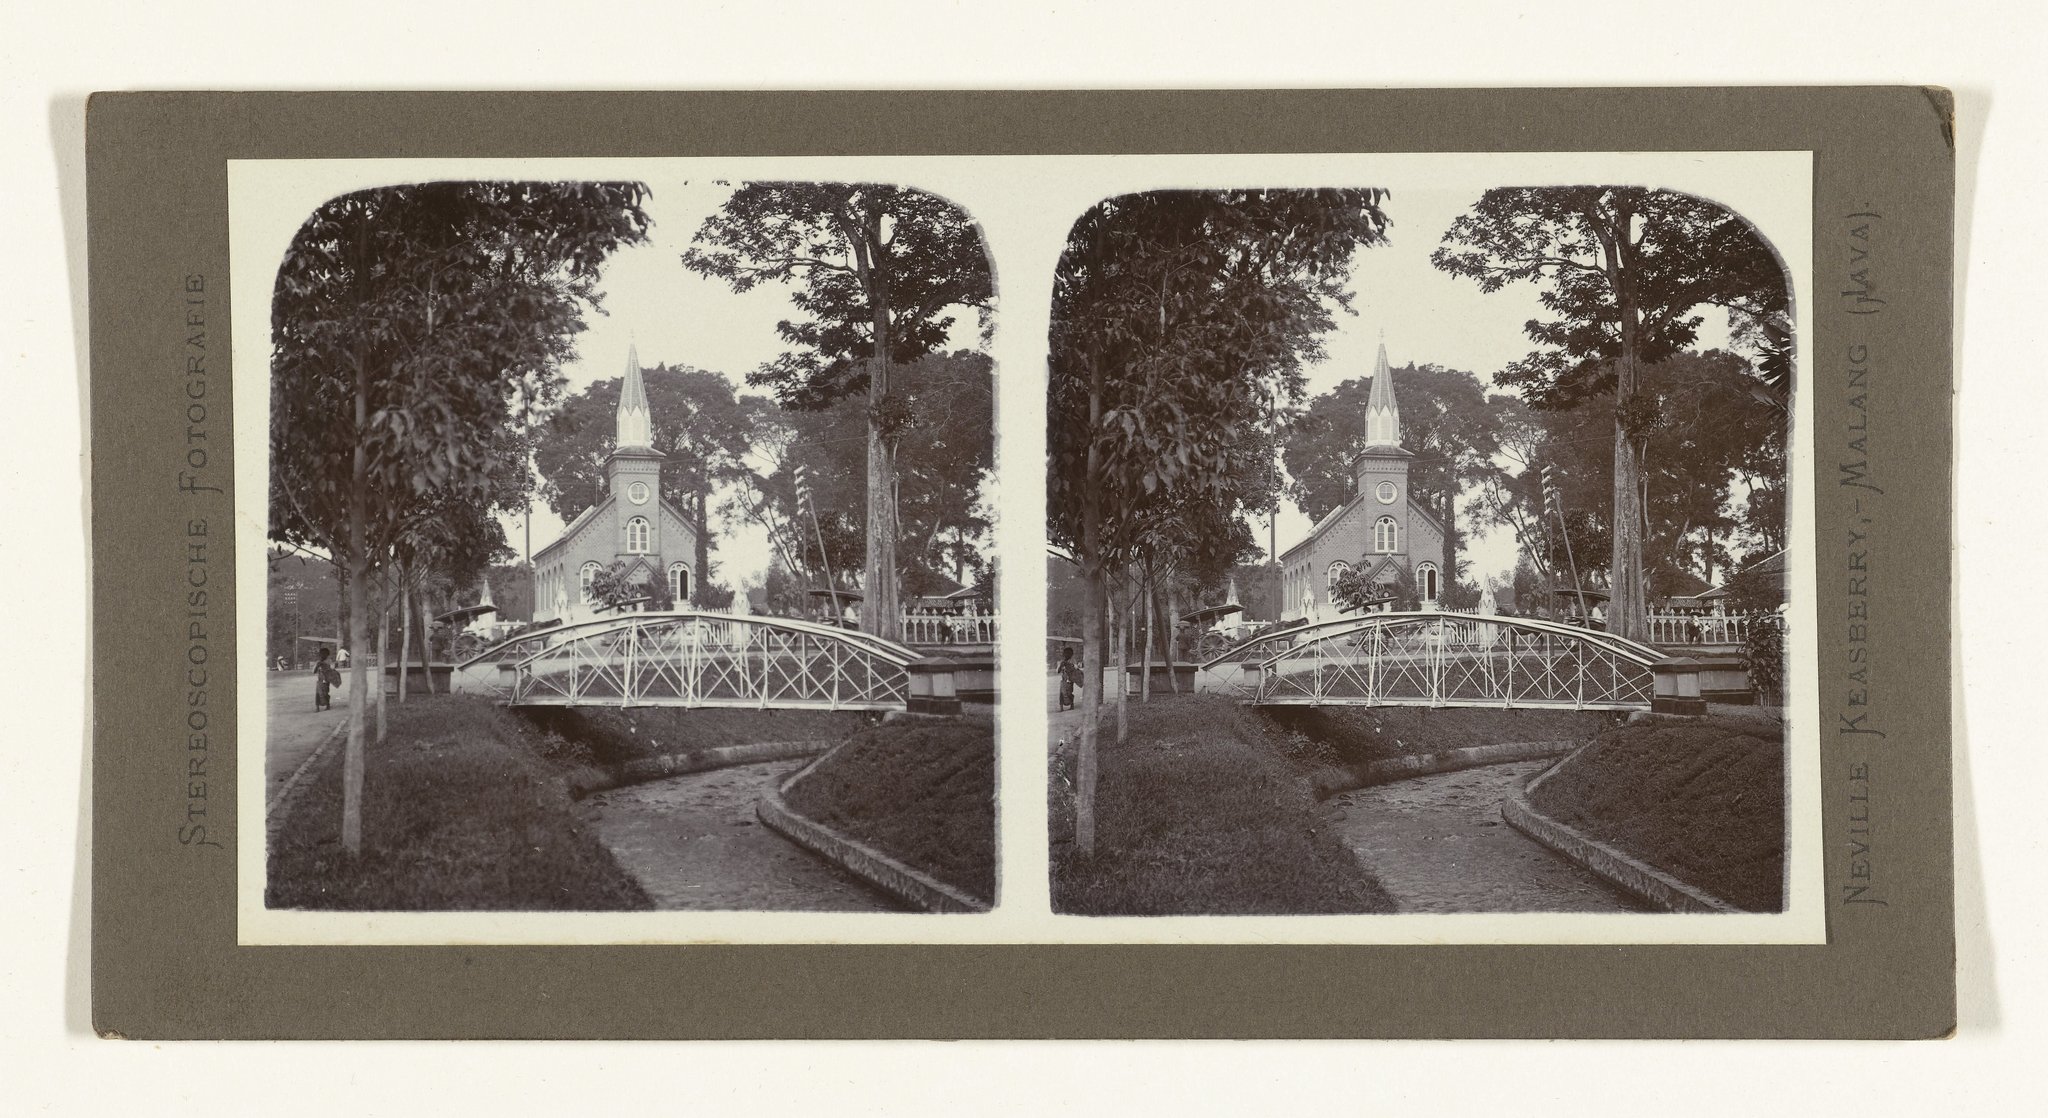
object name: stereograph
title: S 3 No 25. Bandoeng. Ingang Pieterspark met Protest: kerk.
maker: neville keasberry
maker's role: fotograaf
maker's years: 1866-1944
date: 1900-1935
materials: cardboard, paper, photographic support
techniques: albumen print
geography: malang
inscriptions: signature: ‘Neville Keasberry, Malang (Java)’, inscription: ‘Stereoscopische Fotografie’